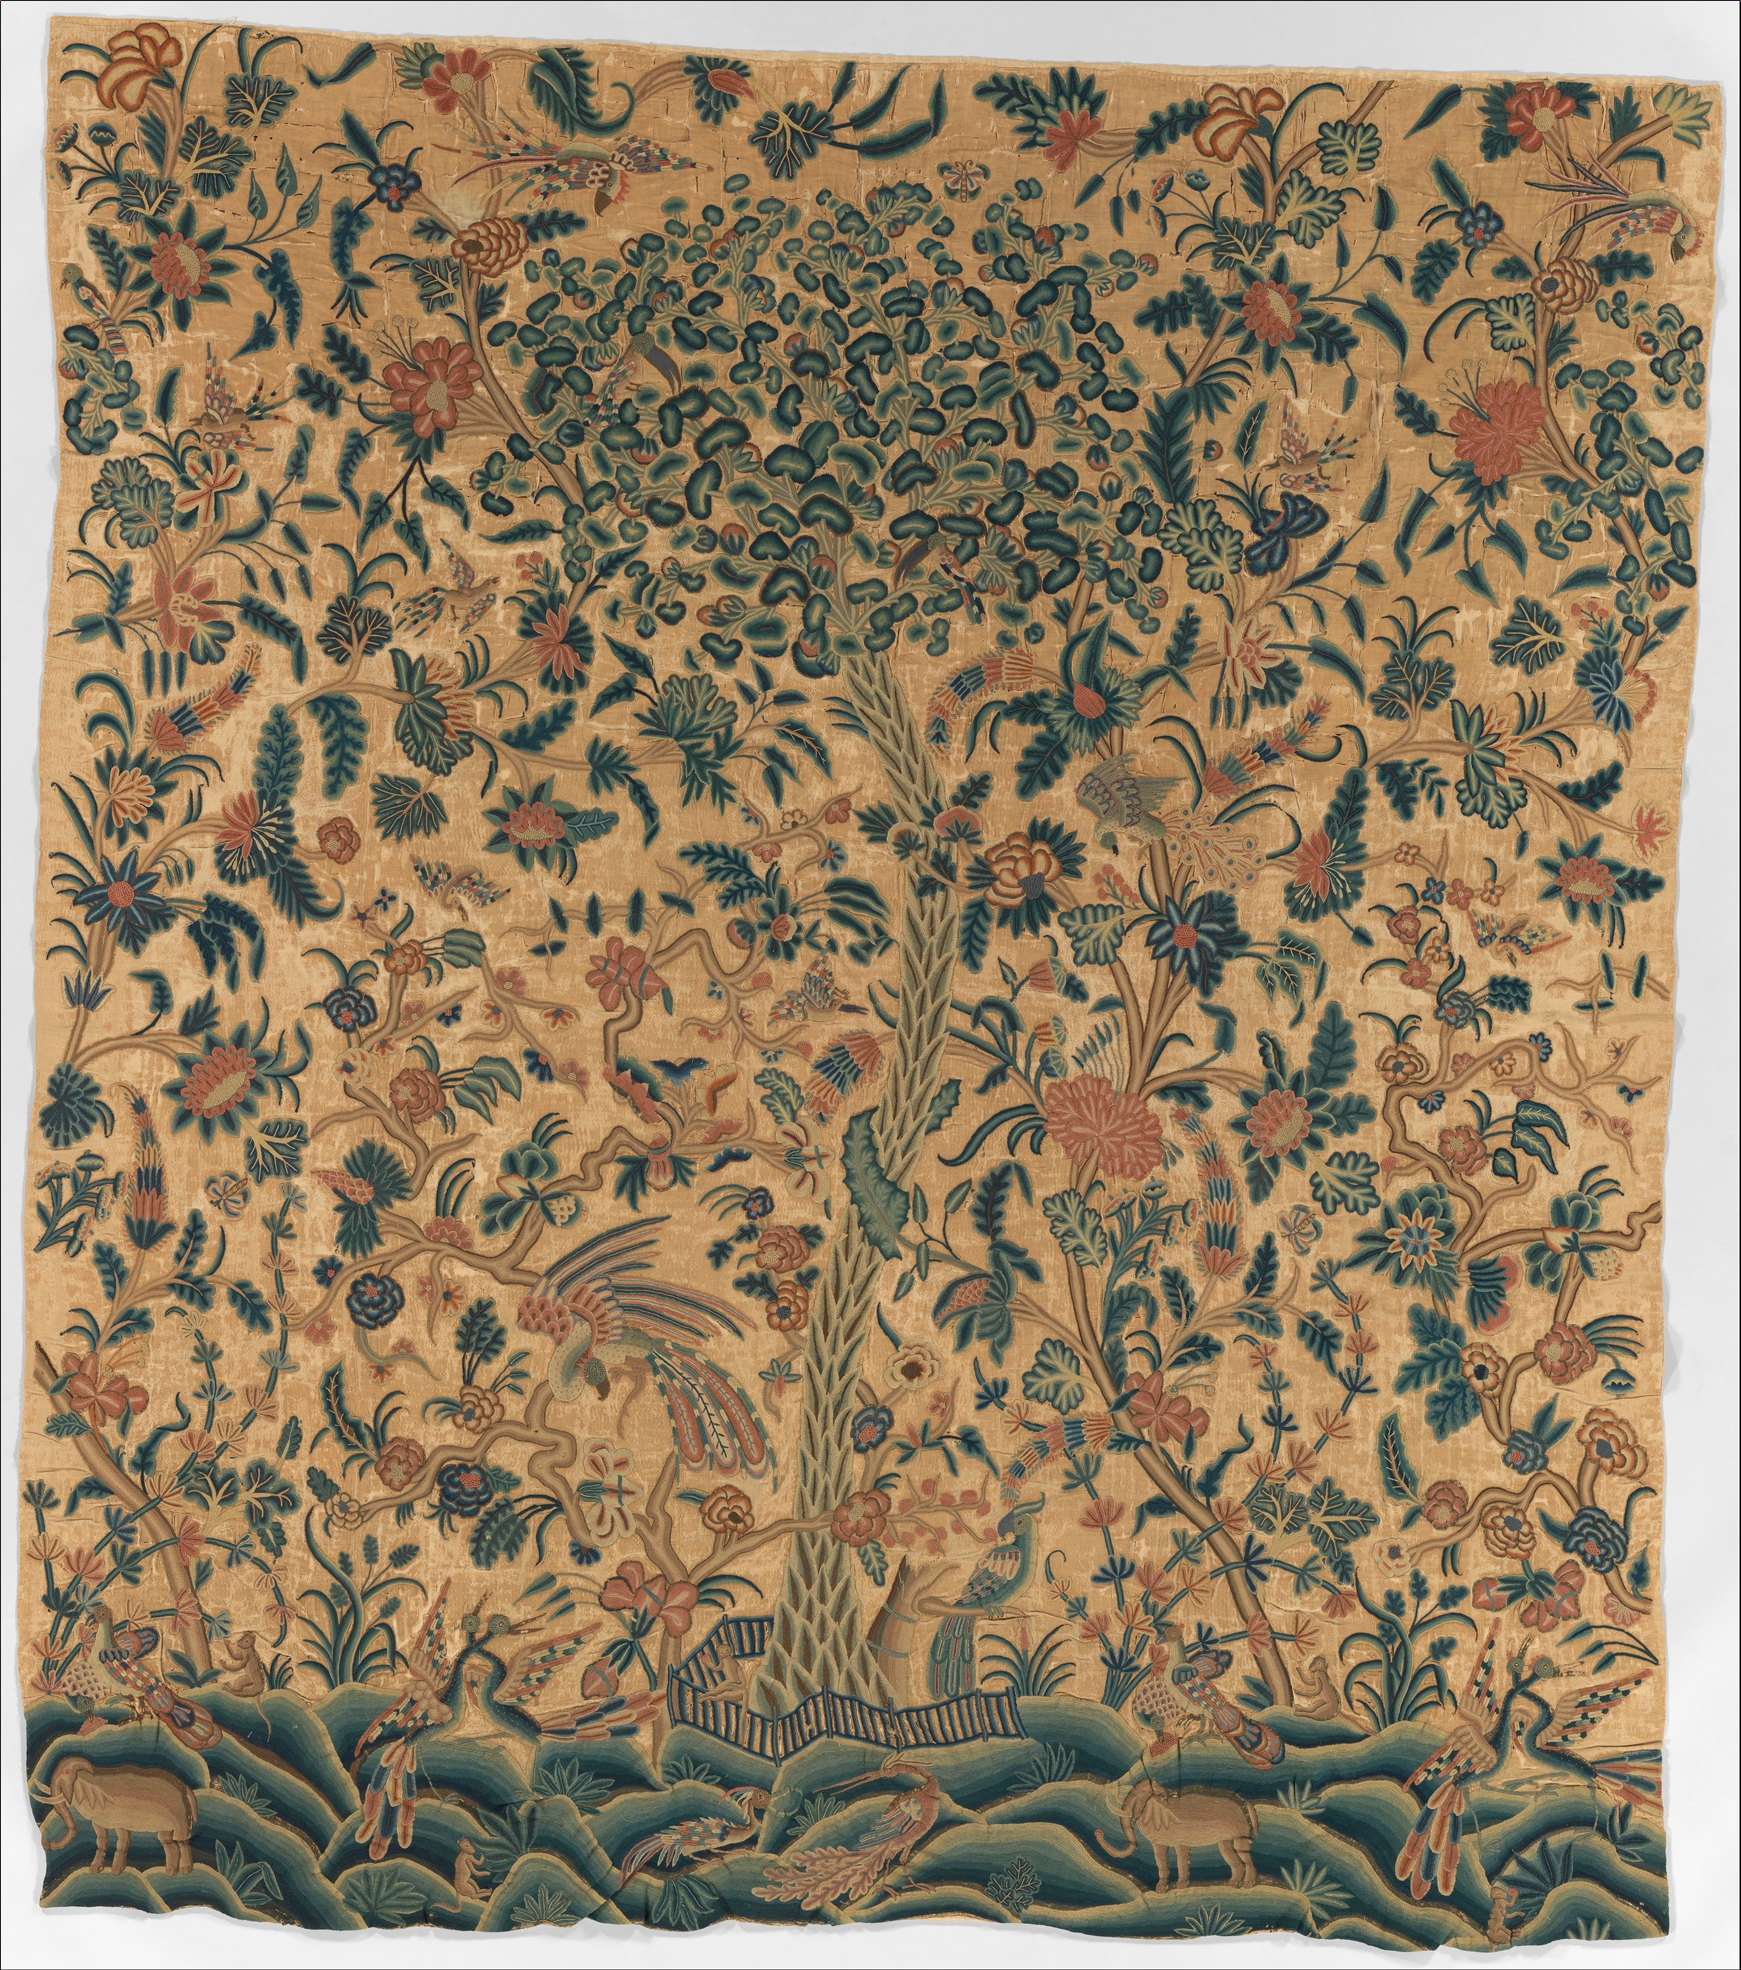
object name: bed hanging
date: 1667-1700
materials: cotton, linen, wool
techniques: weave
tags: birds,elephants,flowers,trees